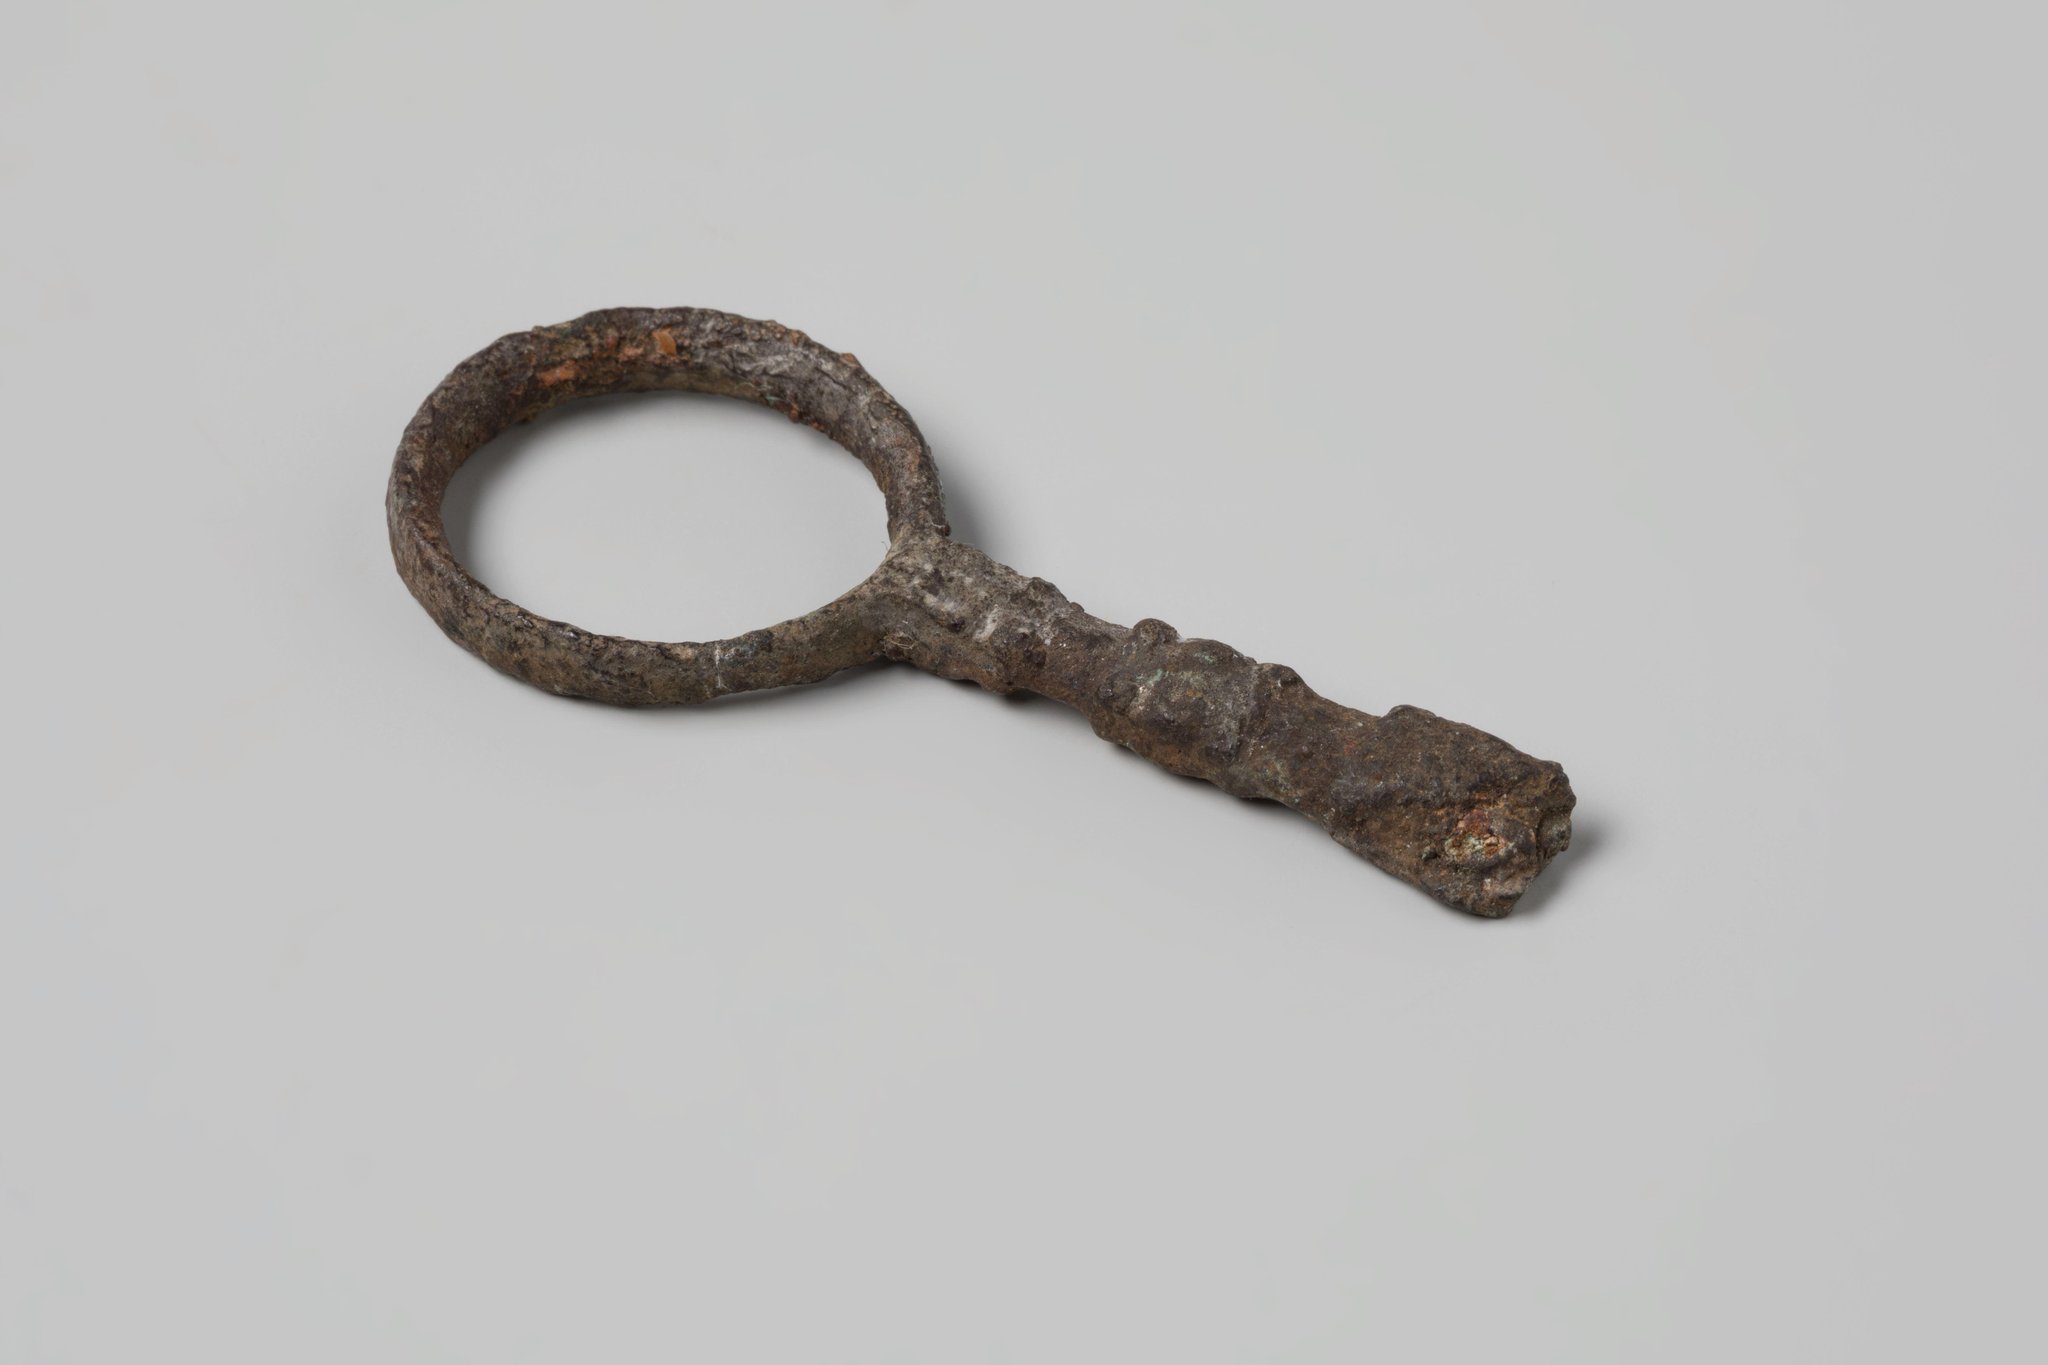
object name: pin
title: Speld uit het wrak van de Oost-Indiëvaarder Hollandia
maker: Anonymous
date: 1700-1743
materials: copper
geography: netherlands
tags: verenigde oostindische compagnie, hollandia (schip), annet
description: Tools and instruments, sewing and sailmaking, pin; fragm of shaft with bow, id. NG 1980-27H3265.